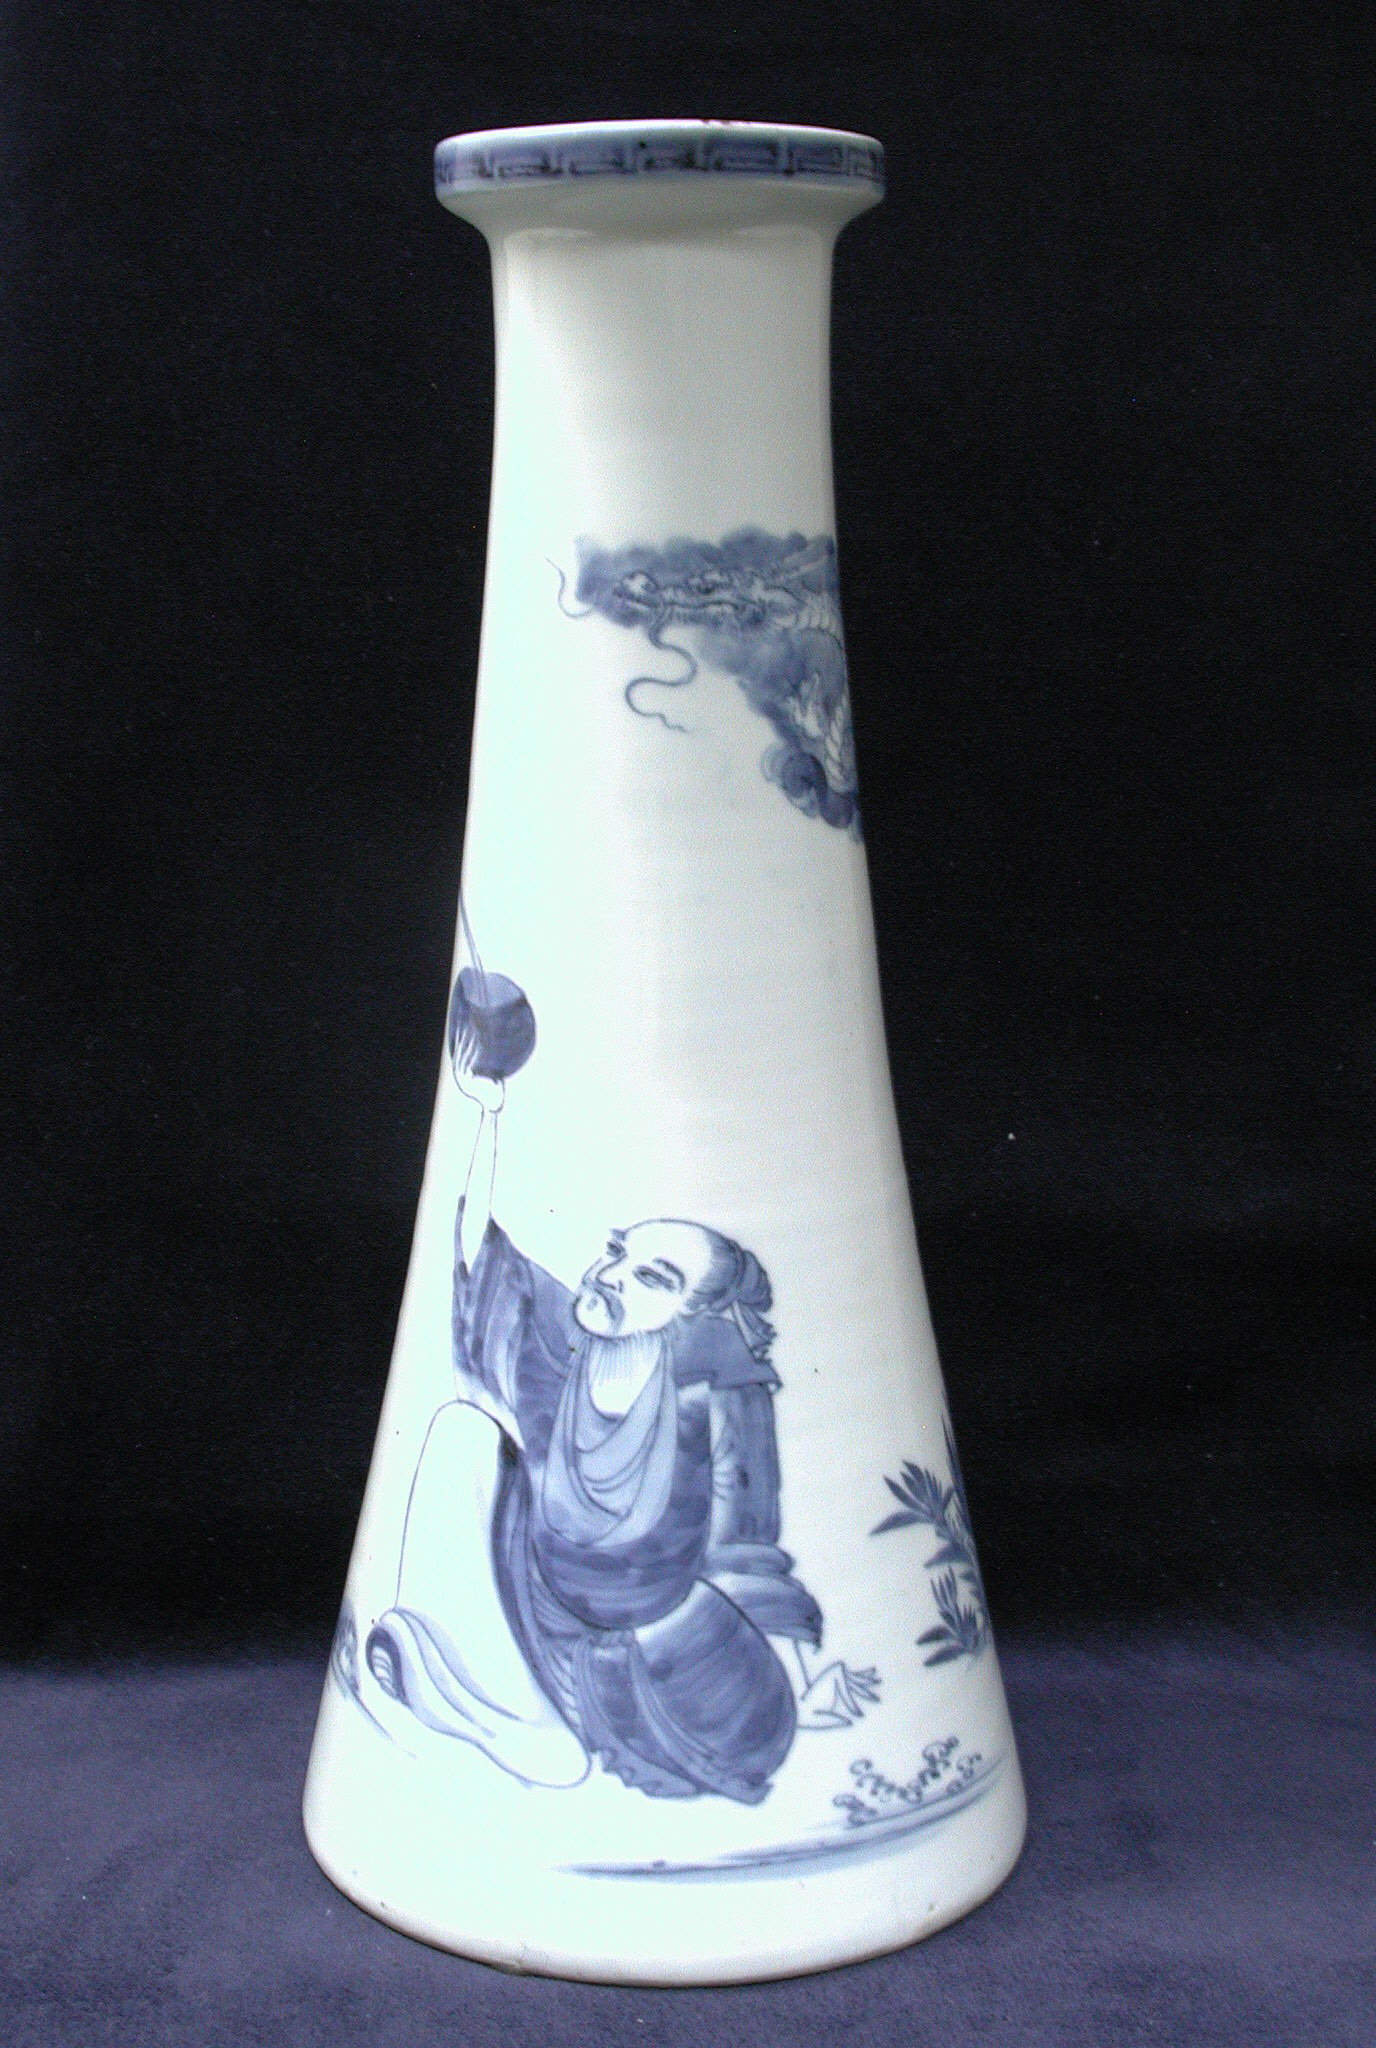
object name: vase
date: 1867-1900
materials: hard paste porcelain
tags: men,dragons